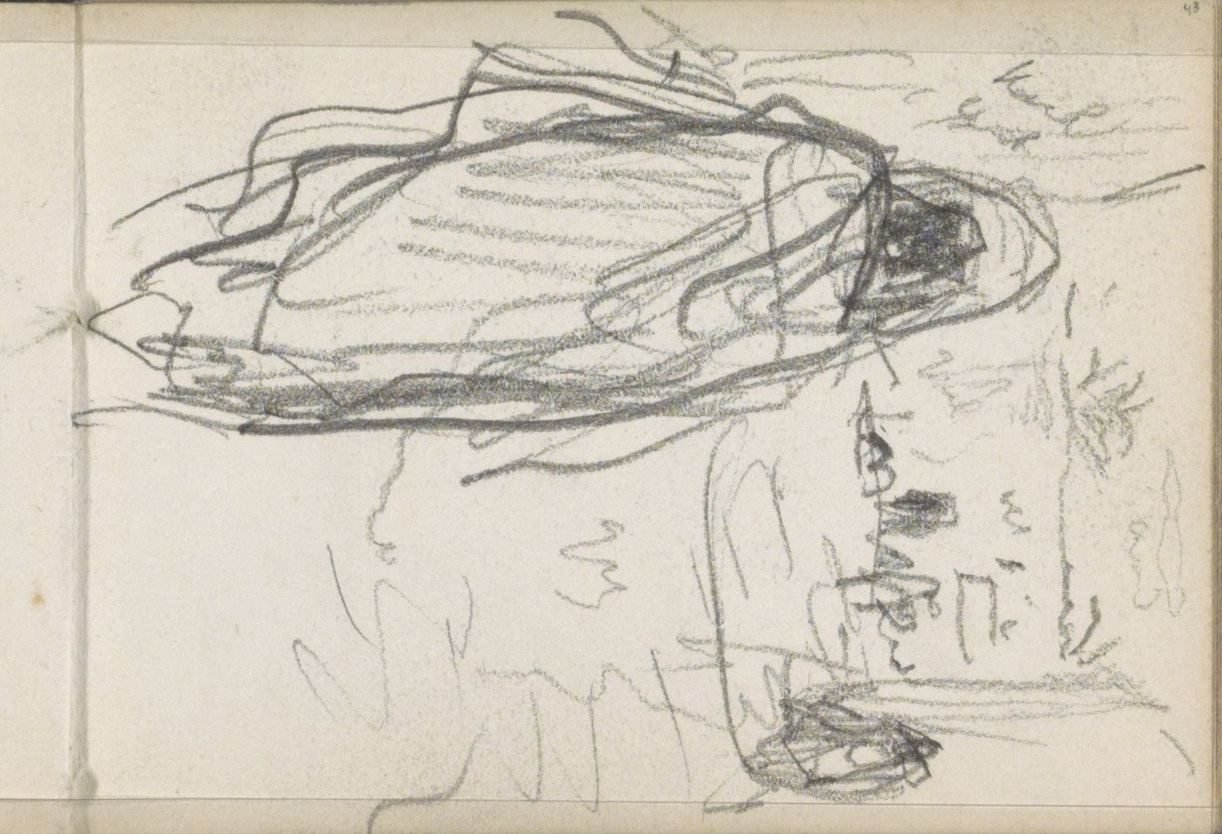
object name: sketchbook leaf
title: Straat met figuren in Biskra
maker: marius bauer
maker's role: draughtsman, print maker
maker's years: 1867-1932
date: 1922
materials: paper, pencil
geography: biskra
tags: africans, folk costume, regional costume, street (+ city(-scape) with figures, staffage)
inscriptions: kleurnotitie, handgeschreven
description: Op de voorgrond een Algerijn in een lang gewaad met hoofddoek. Pagina 43 uit een schetsboek met 32 bladen.